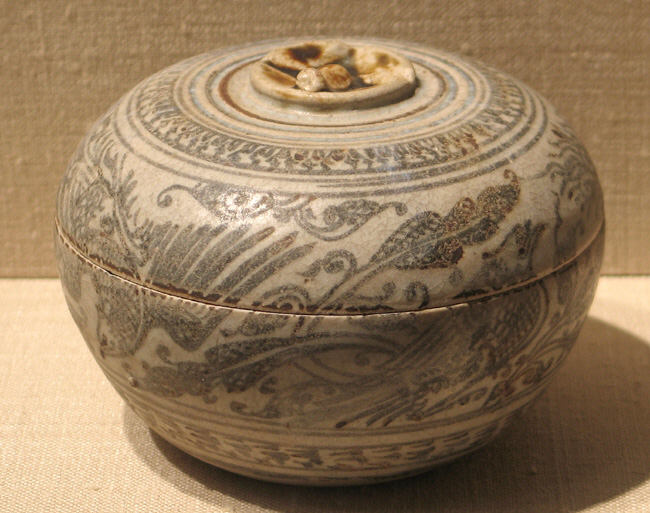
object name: covered box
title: Covered Box with Design of Four Birds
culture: thai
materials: earthenware, glaze, iron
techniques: underglaze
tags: birds